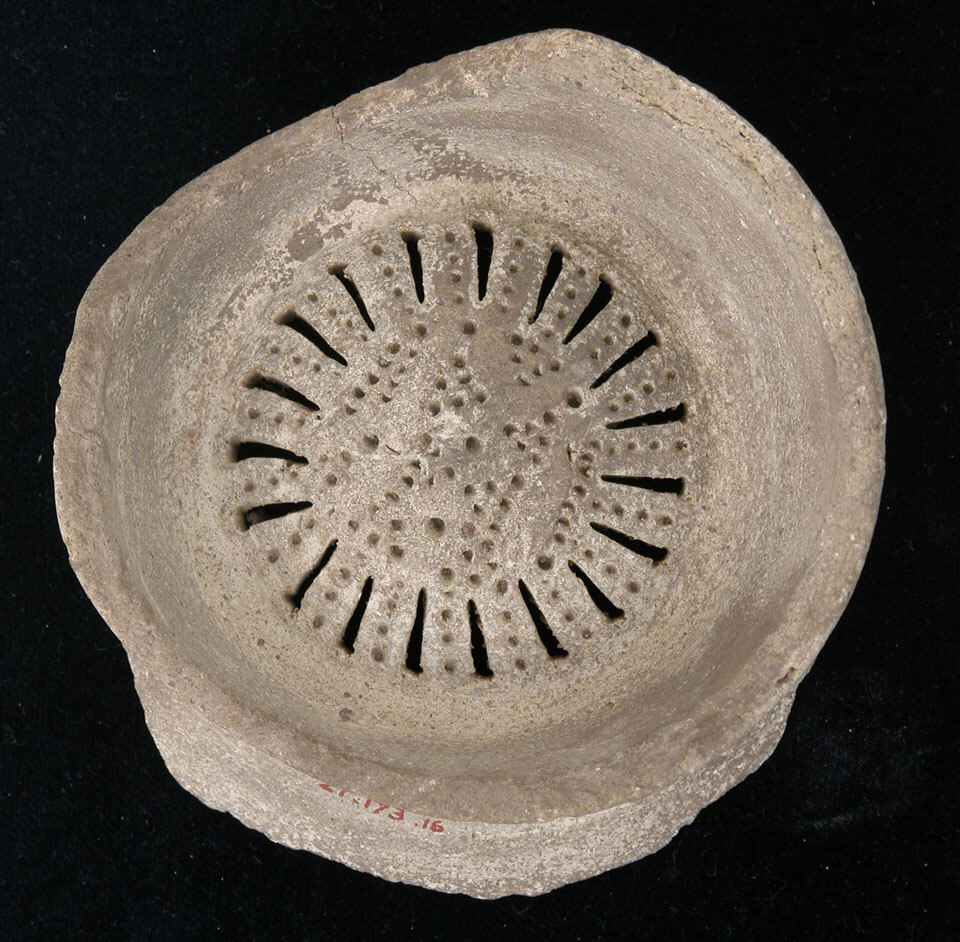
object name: water filter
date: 901-1200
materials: earthenware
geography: egypt